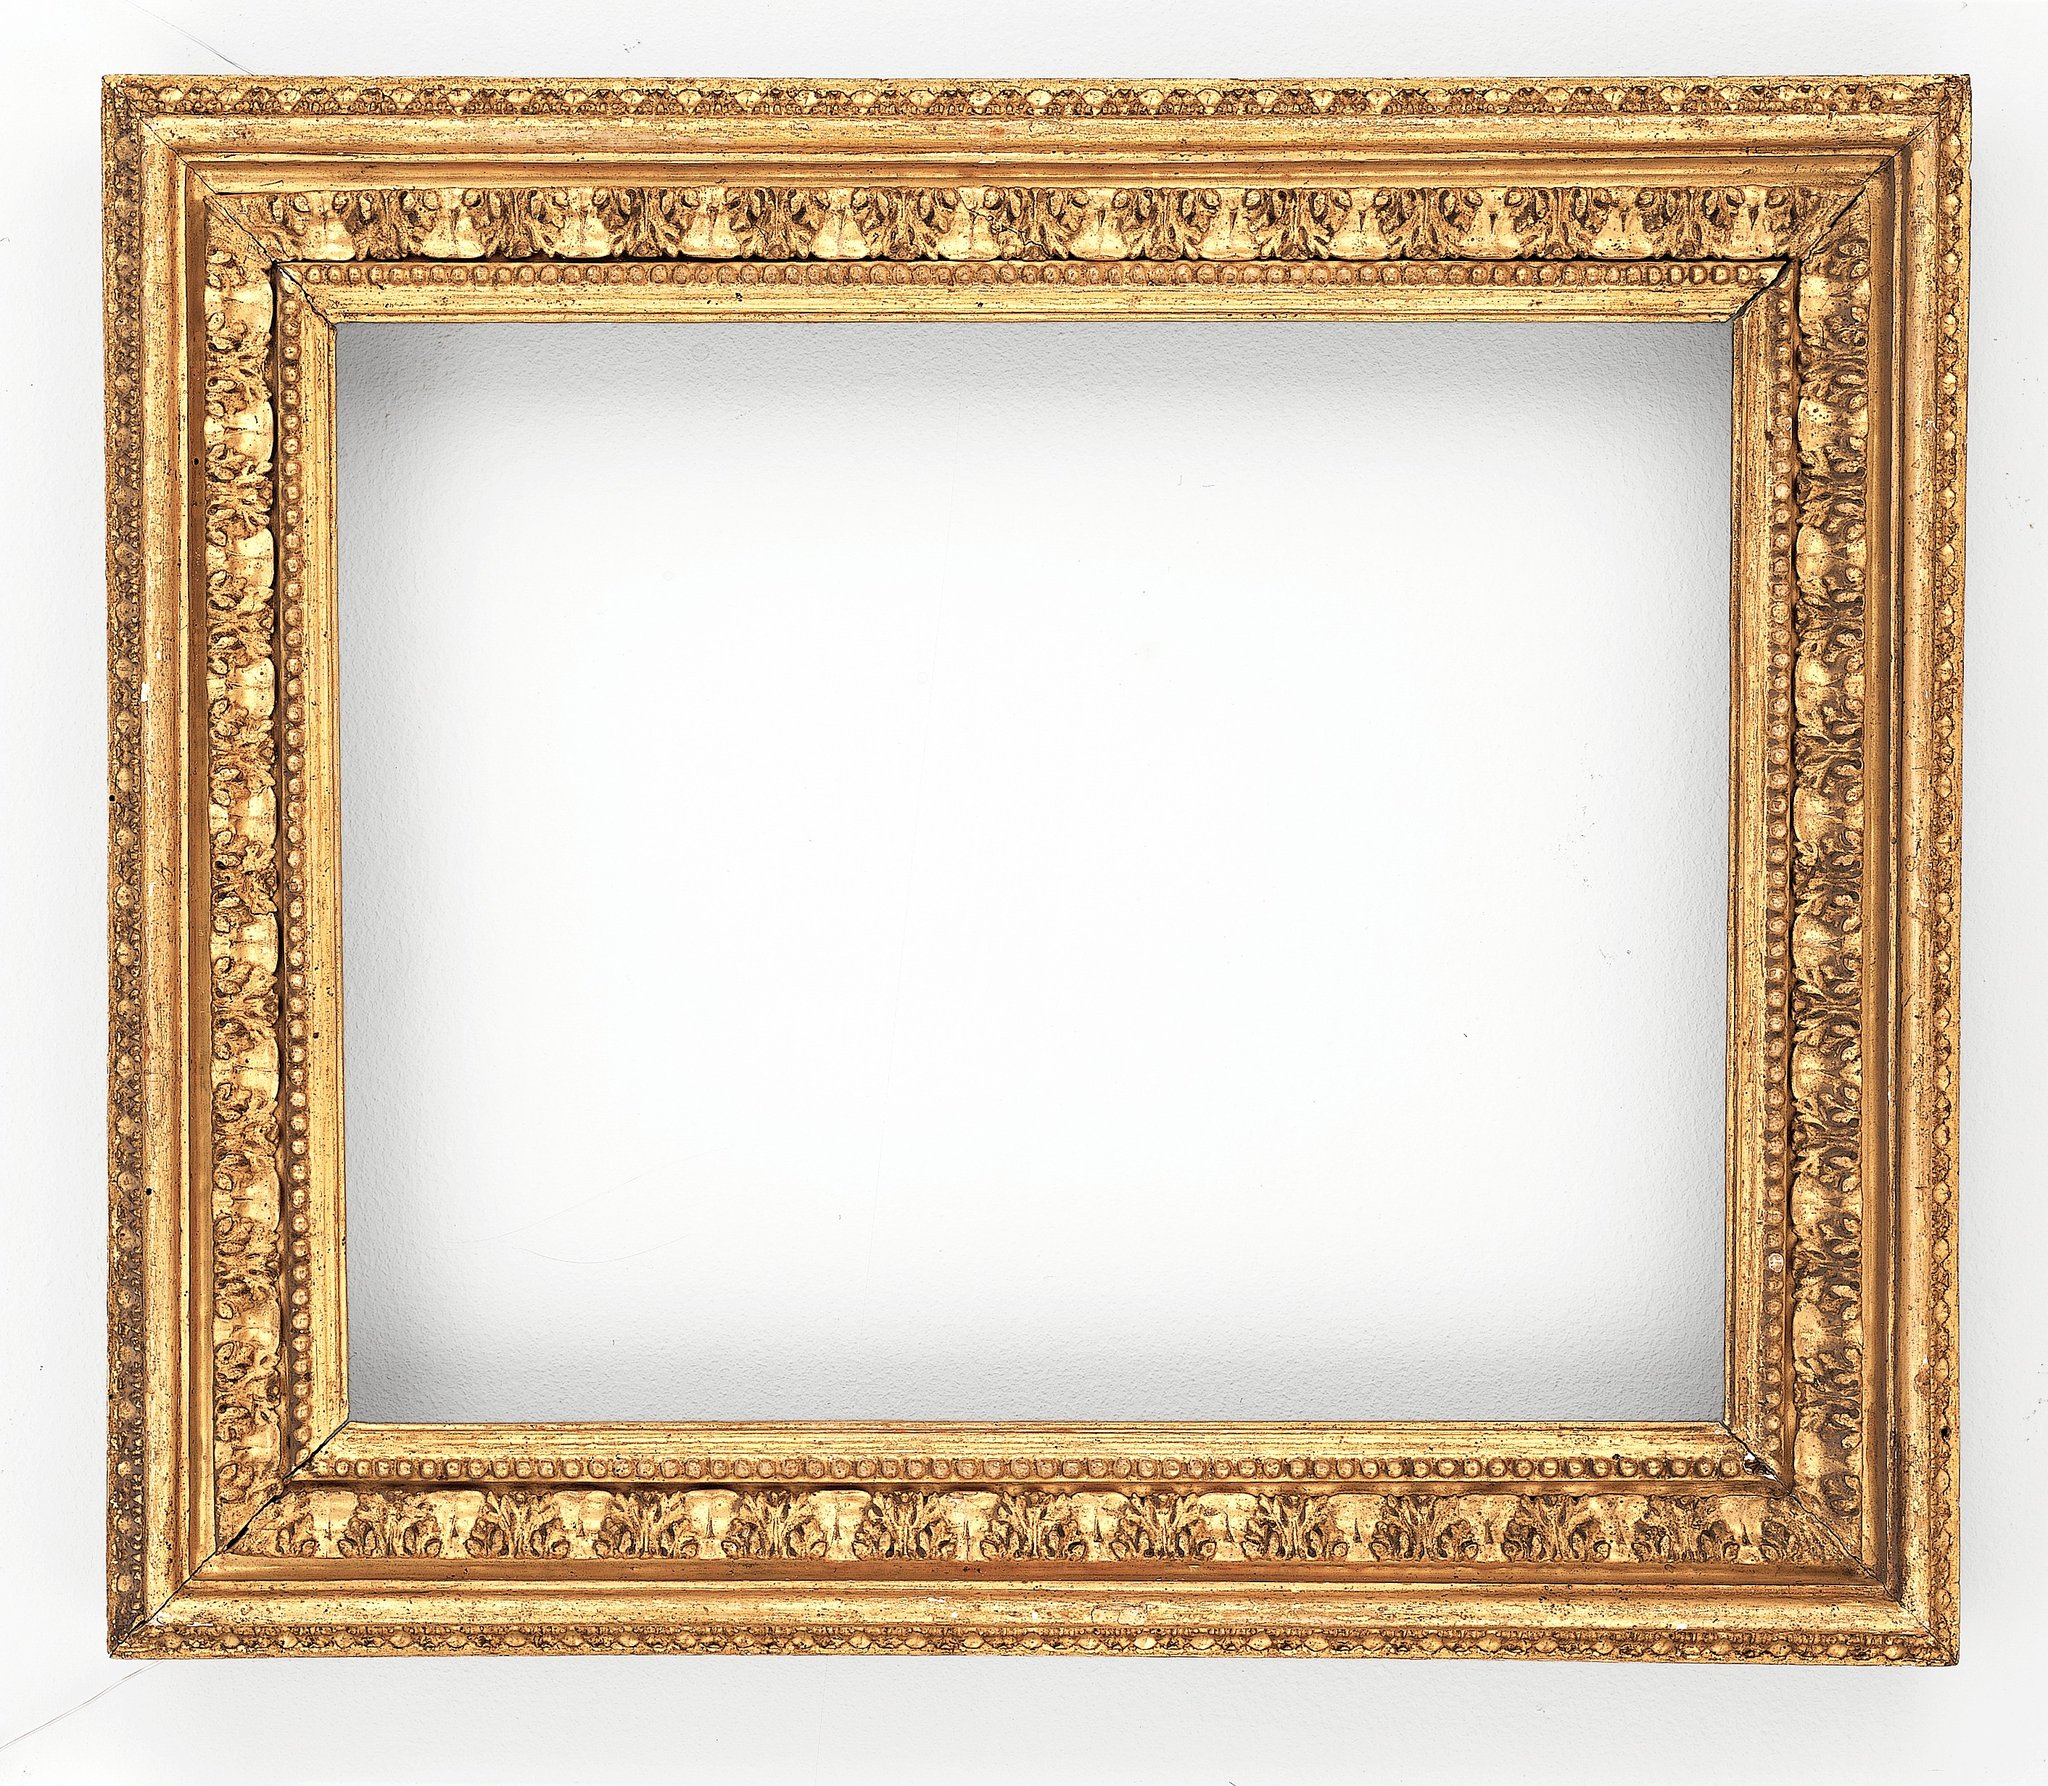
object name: frame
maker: italy (rome)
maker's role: artist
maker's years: 1660-1720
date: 1680-1700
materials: wood